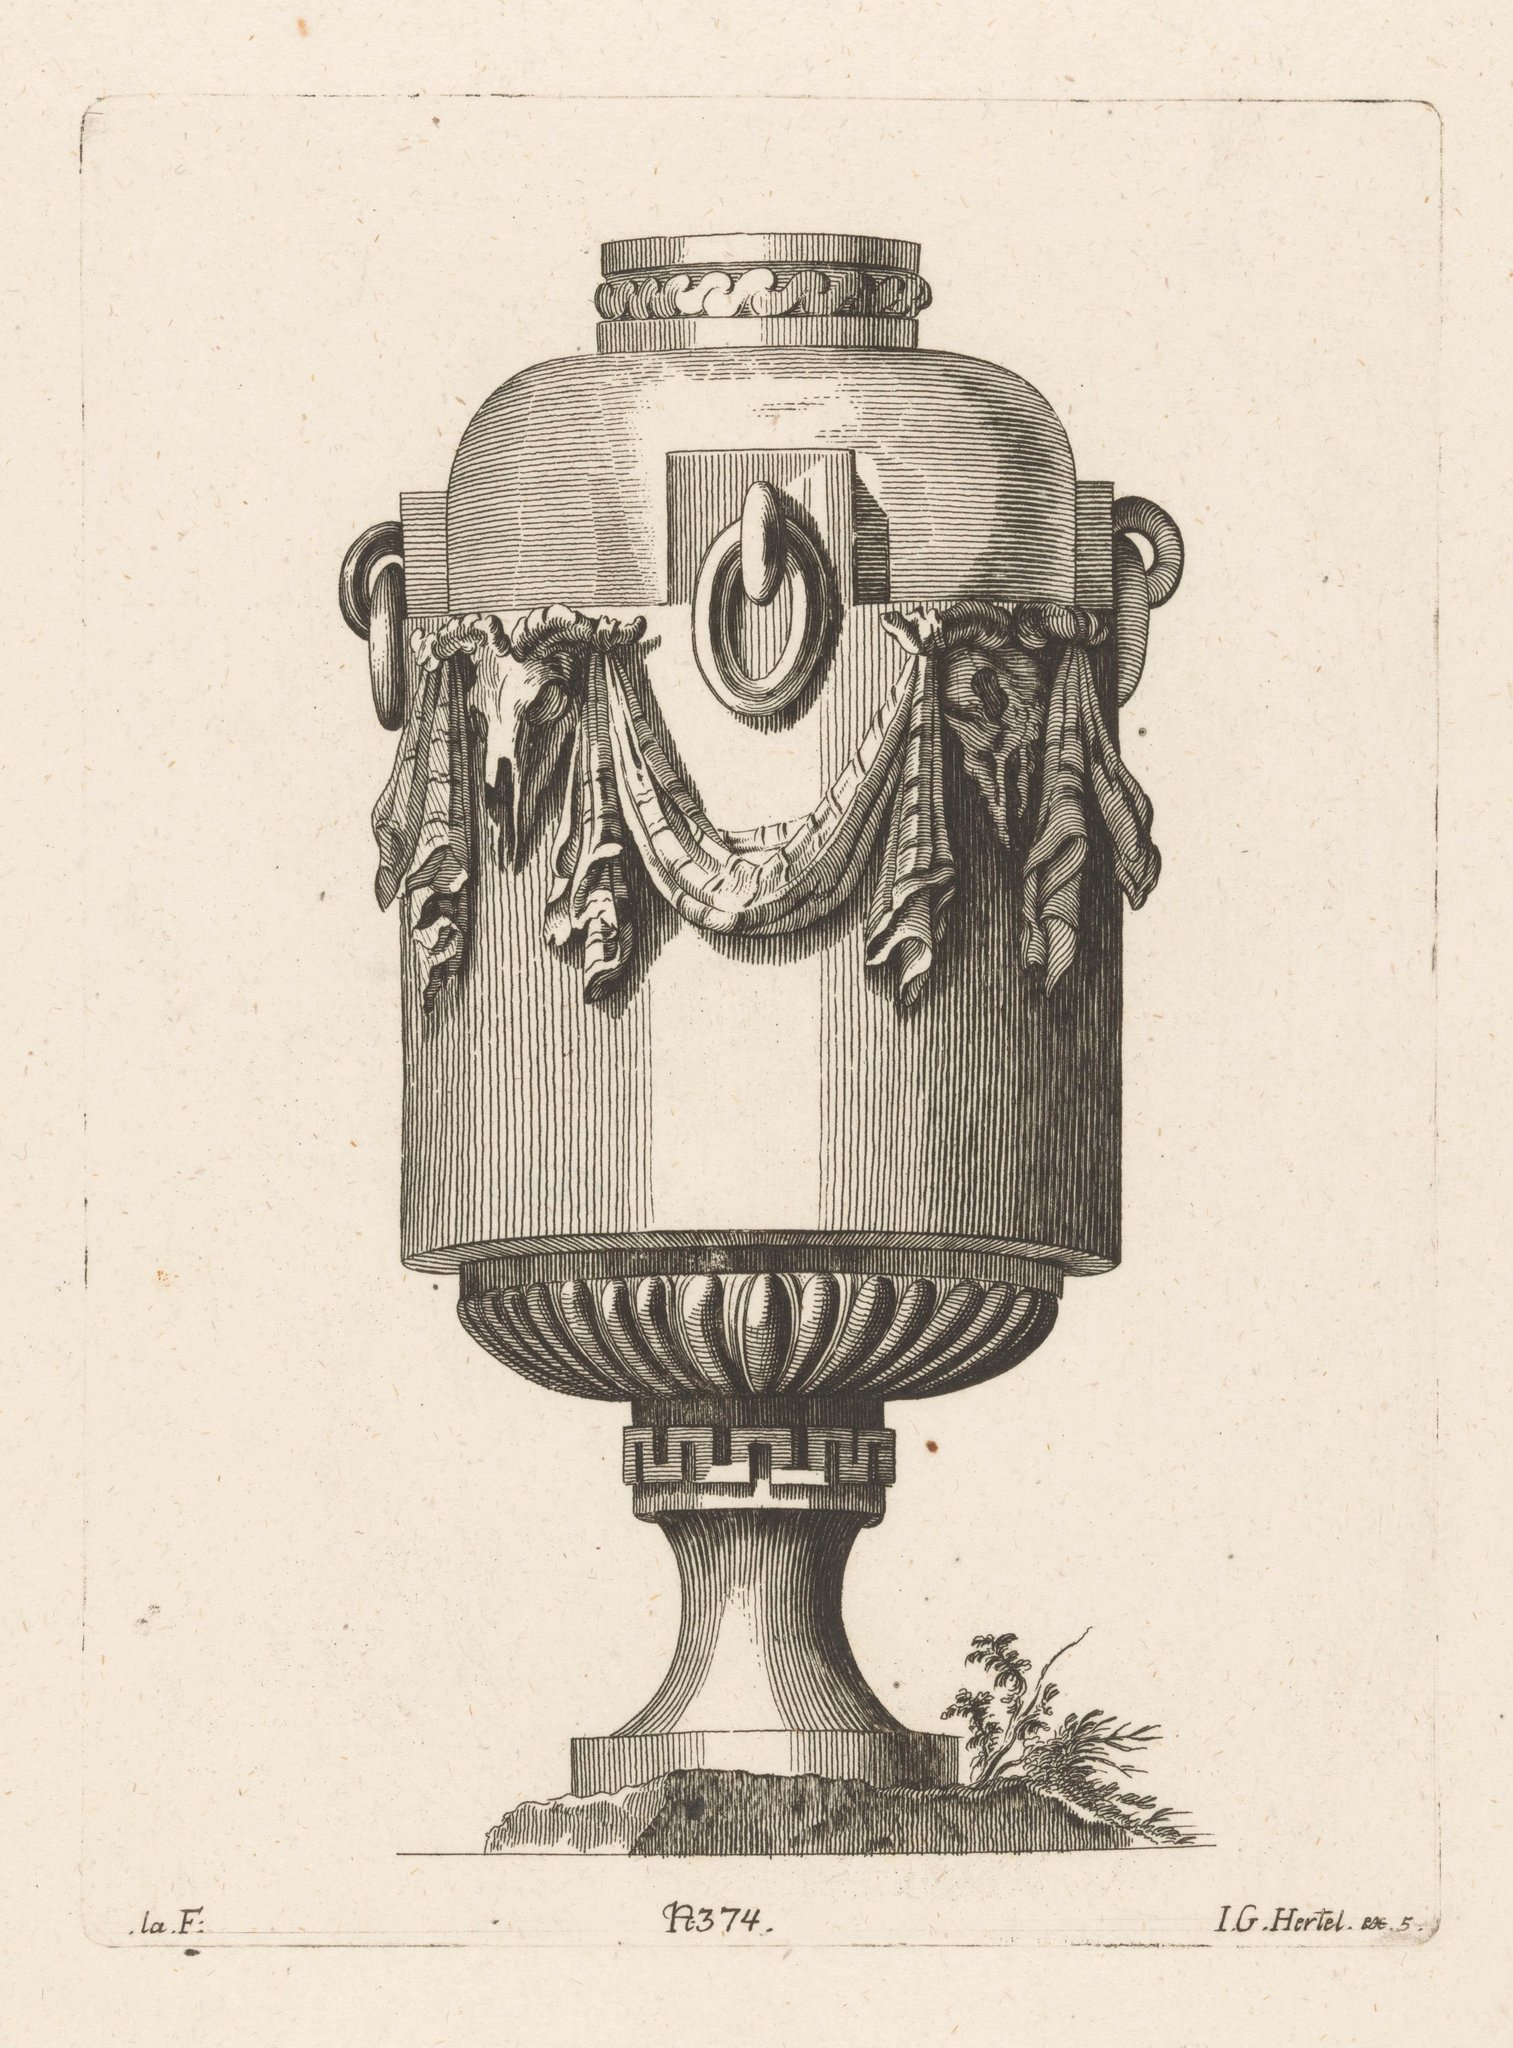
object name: print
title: Vaas met runderschedels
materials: paper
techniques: engraving, etching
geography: germany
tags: vase ~ ornament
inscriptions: collector's mark: Lugt 2228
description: Kopie naar V Vases antiques. Cahier V, IIe Volume De l'Oeuvre de J. Ch. Delafosse (...), prent twee van zes.